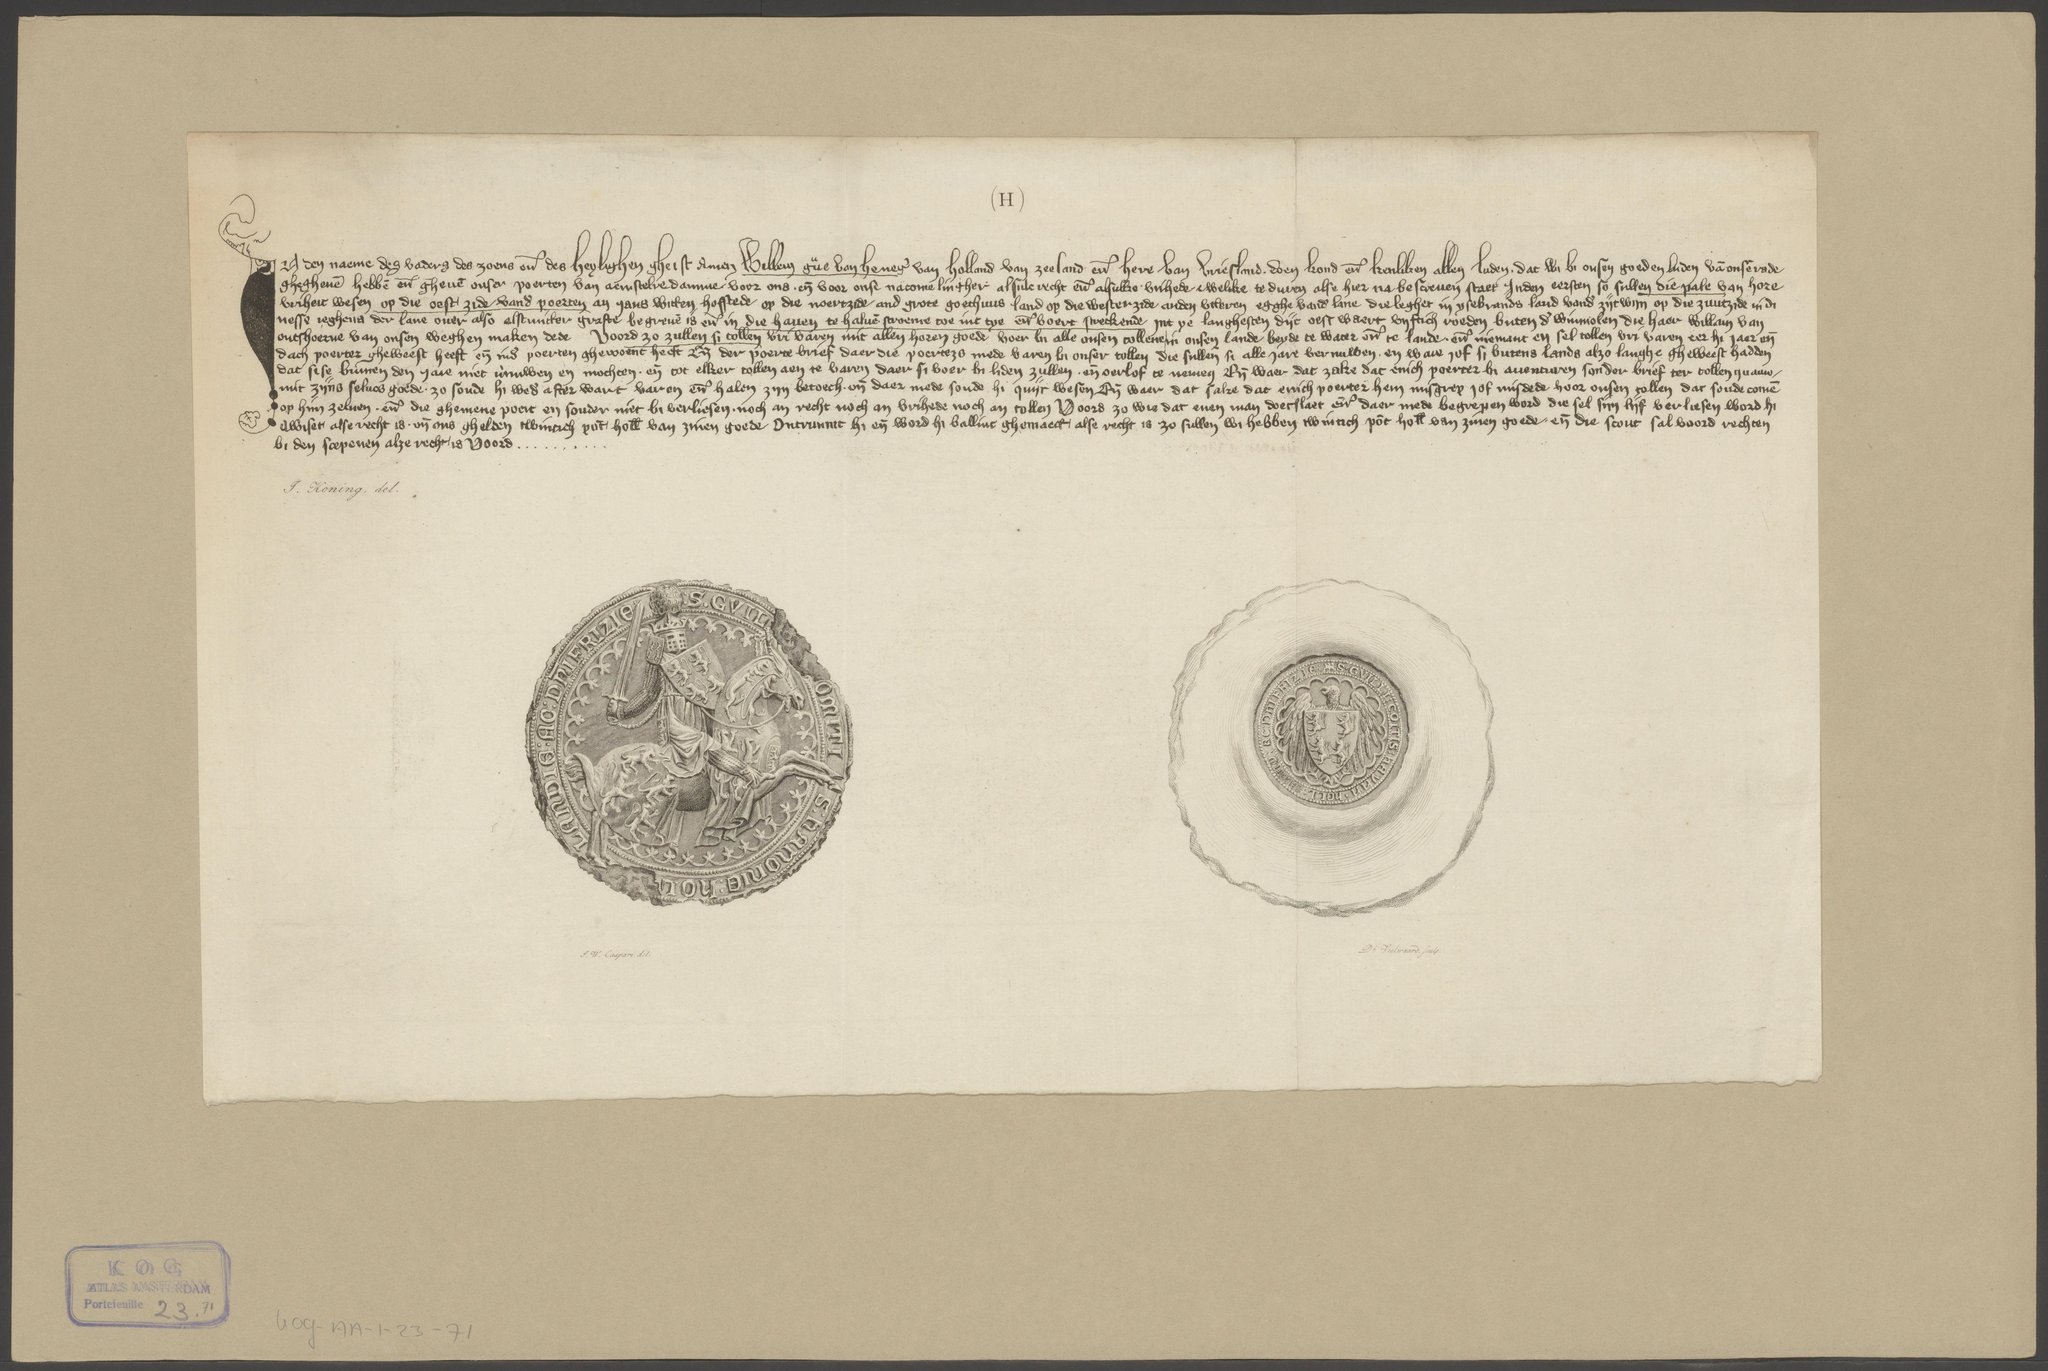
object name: print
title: Privilege van Amsterdam, 1342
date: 1821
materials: paper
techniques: etching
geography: amsterdam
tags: willem iv (graaf van holland), riding a horse, ass, or mule; rider, horseman, coat of arms (symbol of sovereignty), seal, stamp, knight, ruler conferring privileges, amsterdam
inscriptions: collector's mark: Lugt 1641b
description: Prent waarschijnlijk uit: Verhandelingen der Tweede Klasse van het Koninklijk-Nederlandsche Instituut van Wetenschappen, Letterkunden, en Schoone Kunsten te Amsterdam, dl. 2. Amsterdam: Pieper & Ipenbuur, 1821. Of uit: De merkwaardigste stukken uit de oudste archieven van Amsterdam, aangaande de vroegere privilegiën, van deszelfs poorters en inwoners. Amsterdam: Pieper & Ipenbuur, 1821.